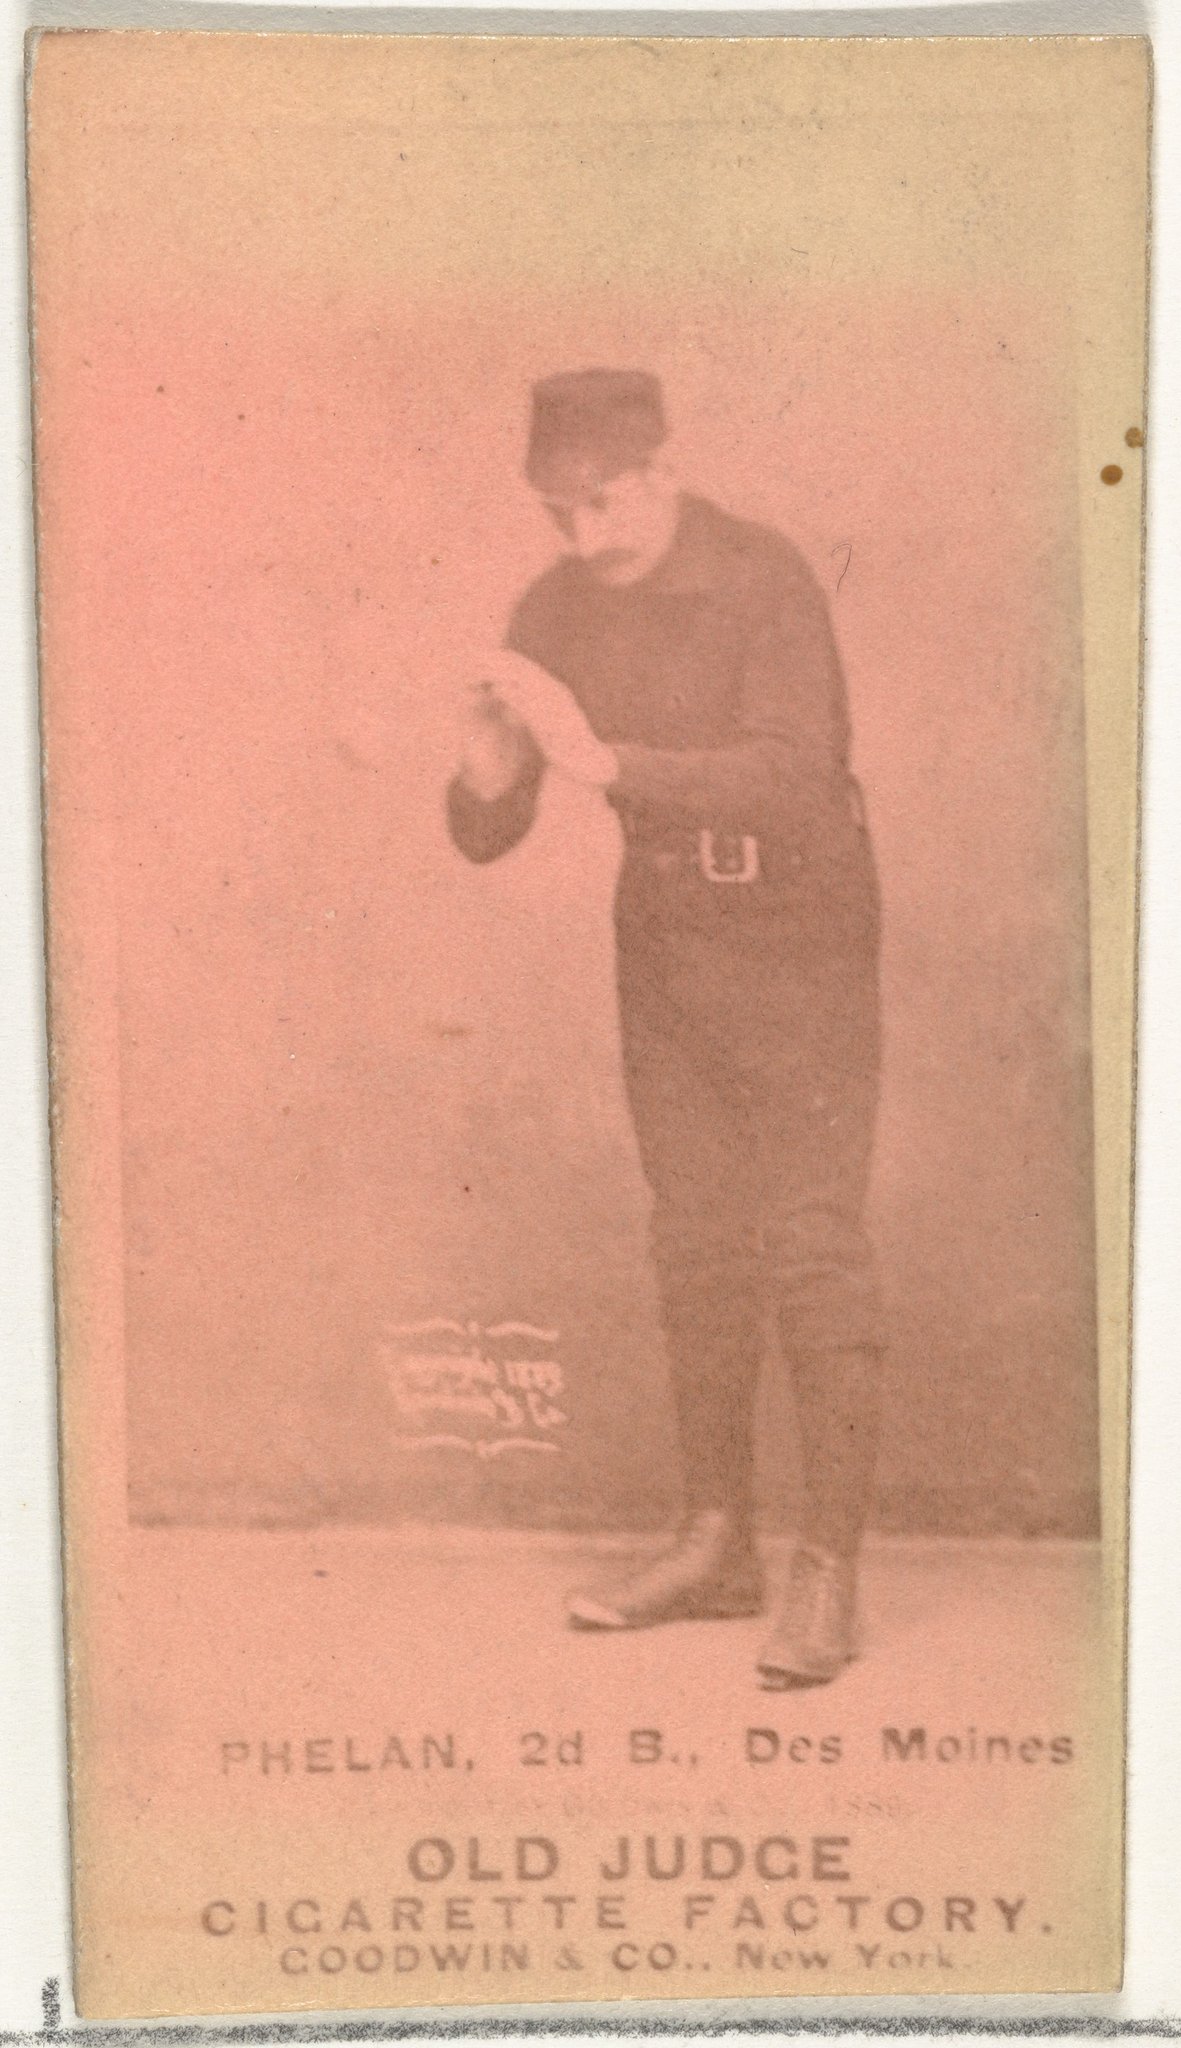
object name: baseball card, photograph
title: James Dickson "Dick" Phelan, 2nd Base, Des Moines Prohibitionists, from the Old Judge series (N172) for Old Judge Cigarettes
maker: goodwin & company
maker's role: publisher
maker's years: 1850-1950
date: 1888-1889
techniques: albumen silver print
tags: men,portraits,baseball,athletes